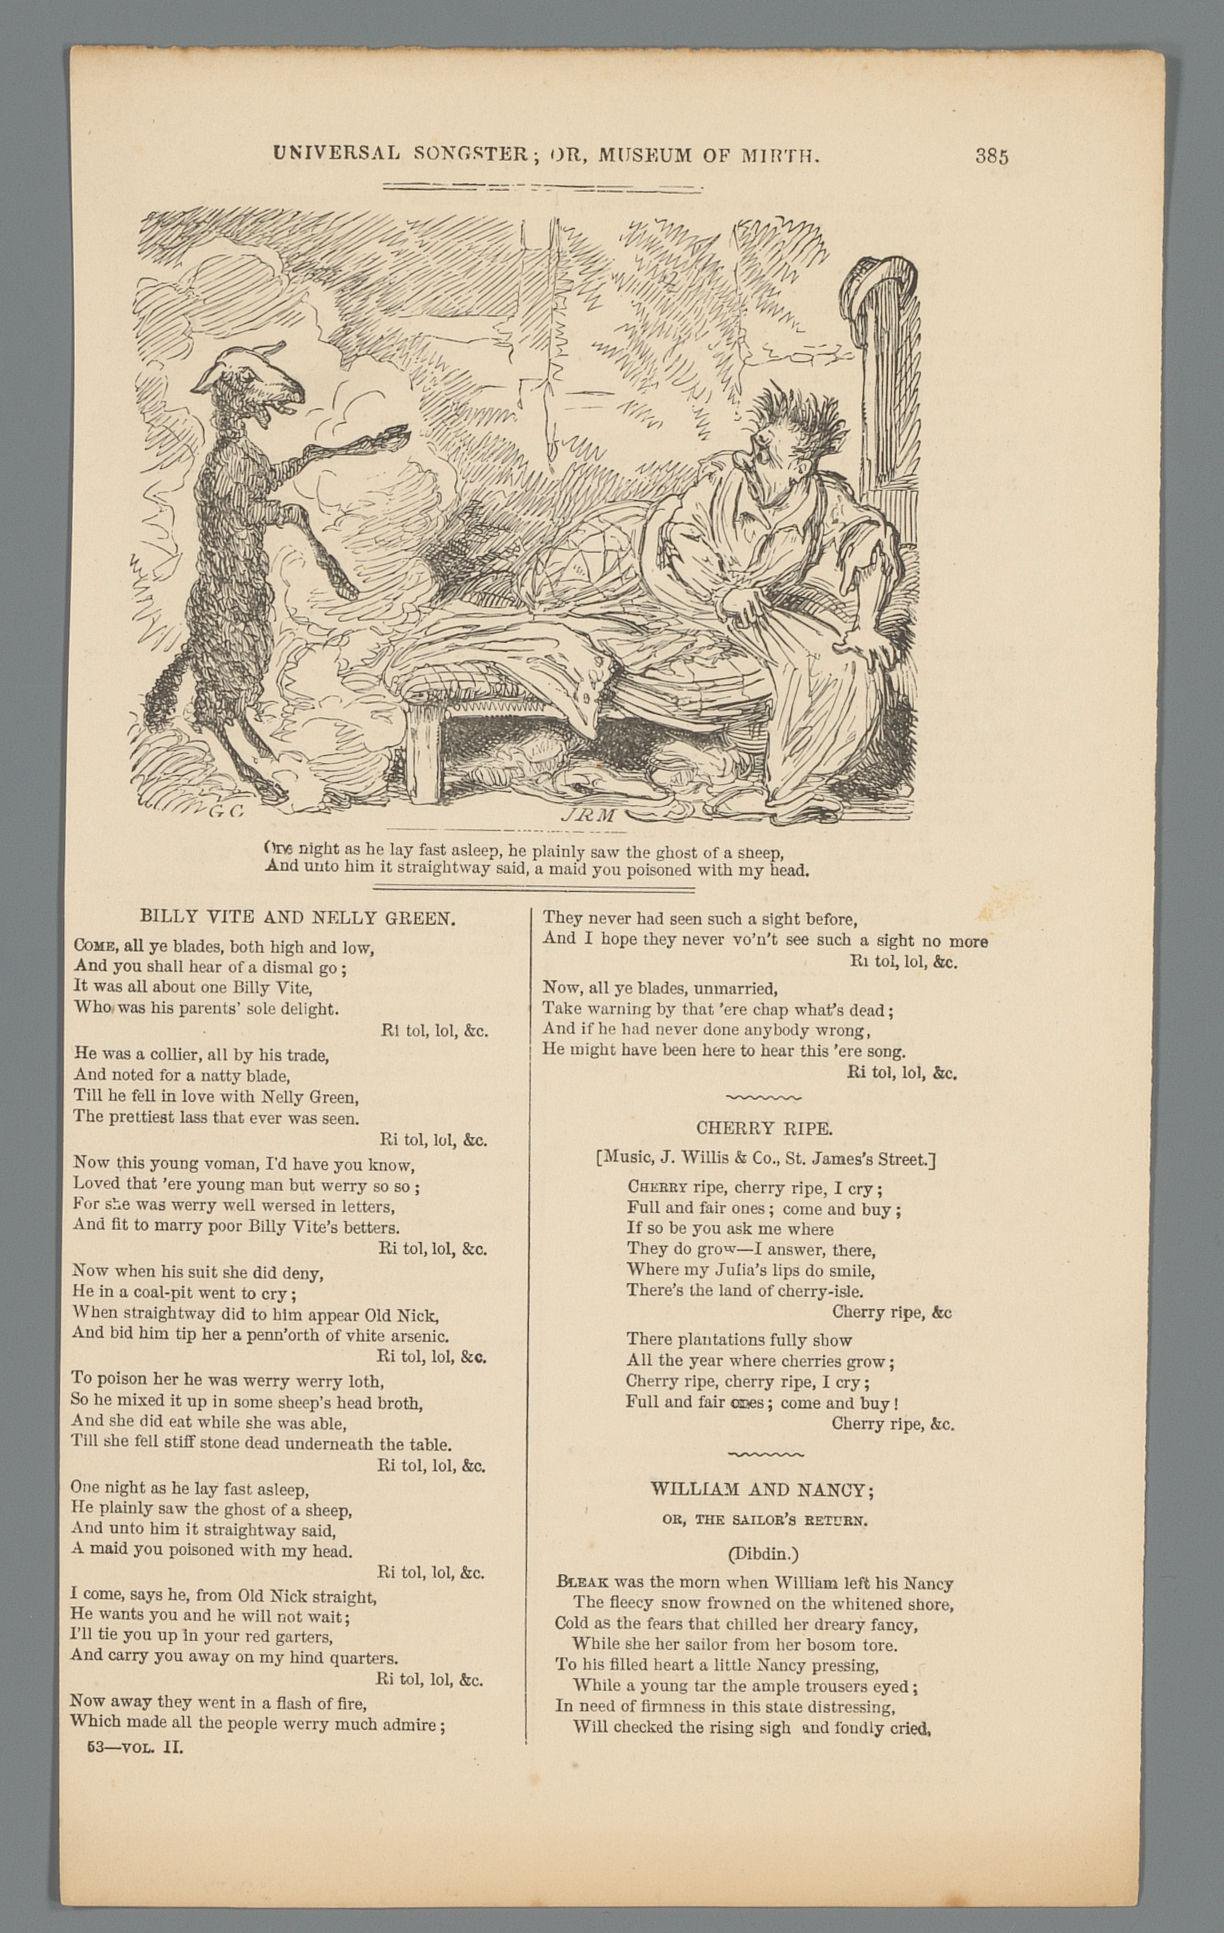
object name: book illustration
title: Spotprent bij het lied: Billy Vite and Nelly Green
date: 1826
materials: paper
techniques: engraving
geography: england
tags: sheep, dream, materialization, appearance of spirit or ghost, political caricatures and satires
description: De geest van een schaap verschijnt aan het bed van een doodsbange man die een vrouw had vergiftigd met gif in een schaapskop. Spotprent bij een blad met de tekst van het lied: Billy Vite and Nelly Green. Illustratie (p. 385/386) genomen uit een uitgave van de liederenbundel: Universal Songster, or Museum of Mirth, vol. II., eerst verschenen in 1826.